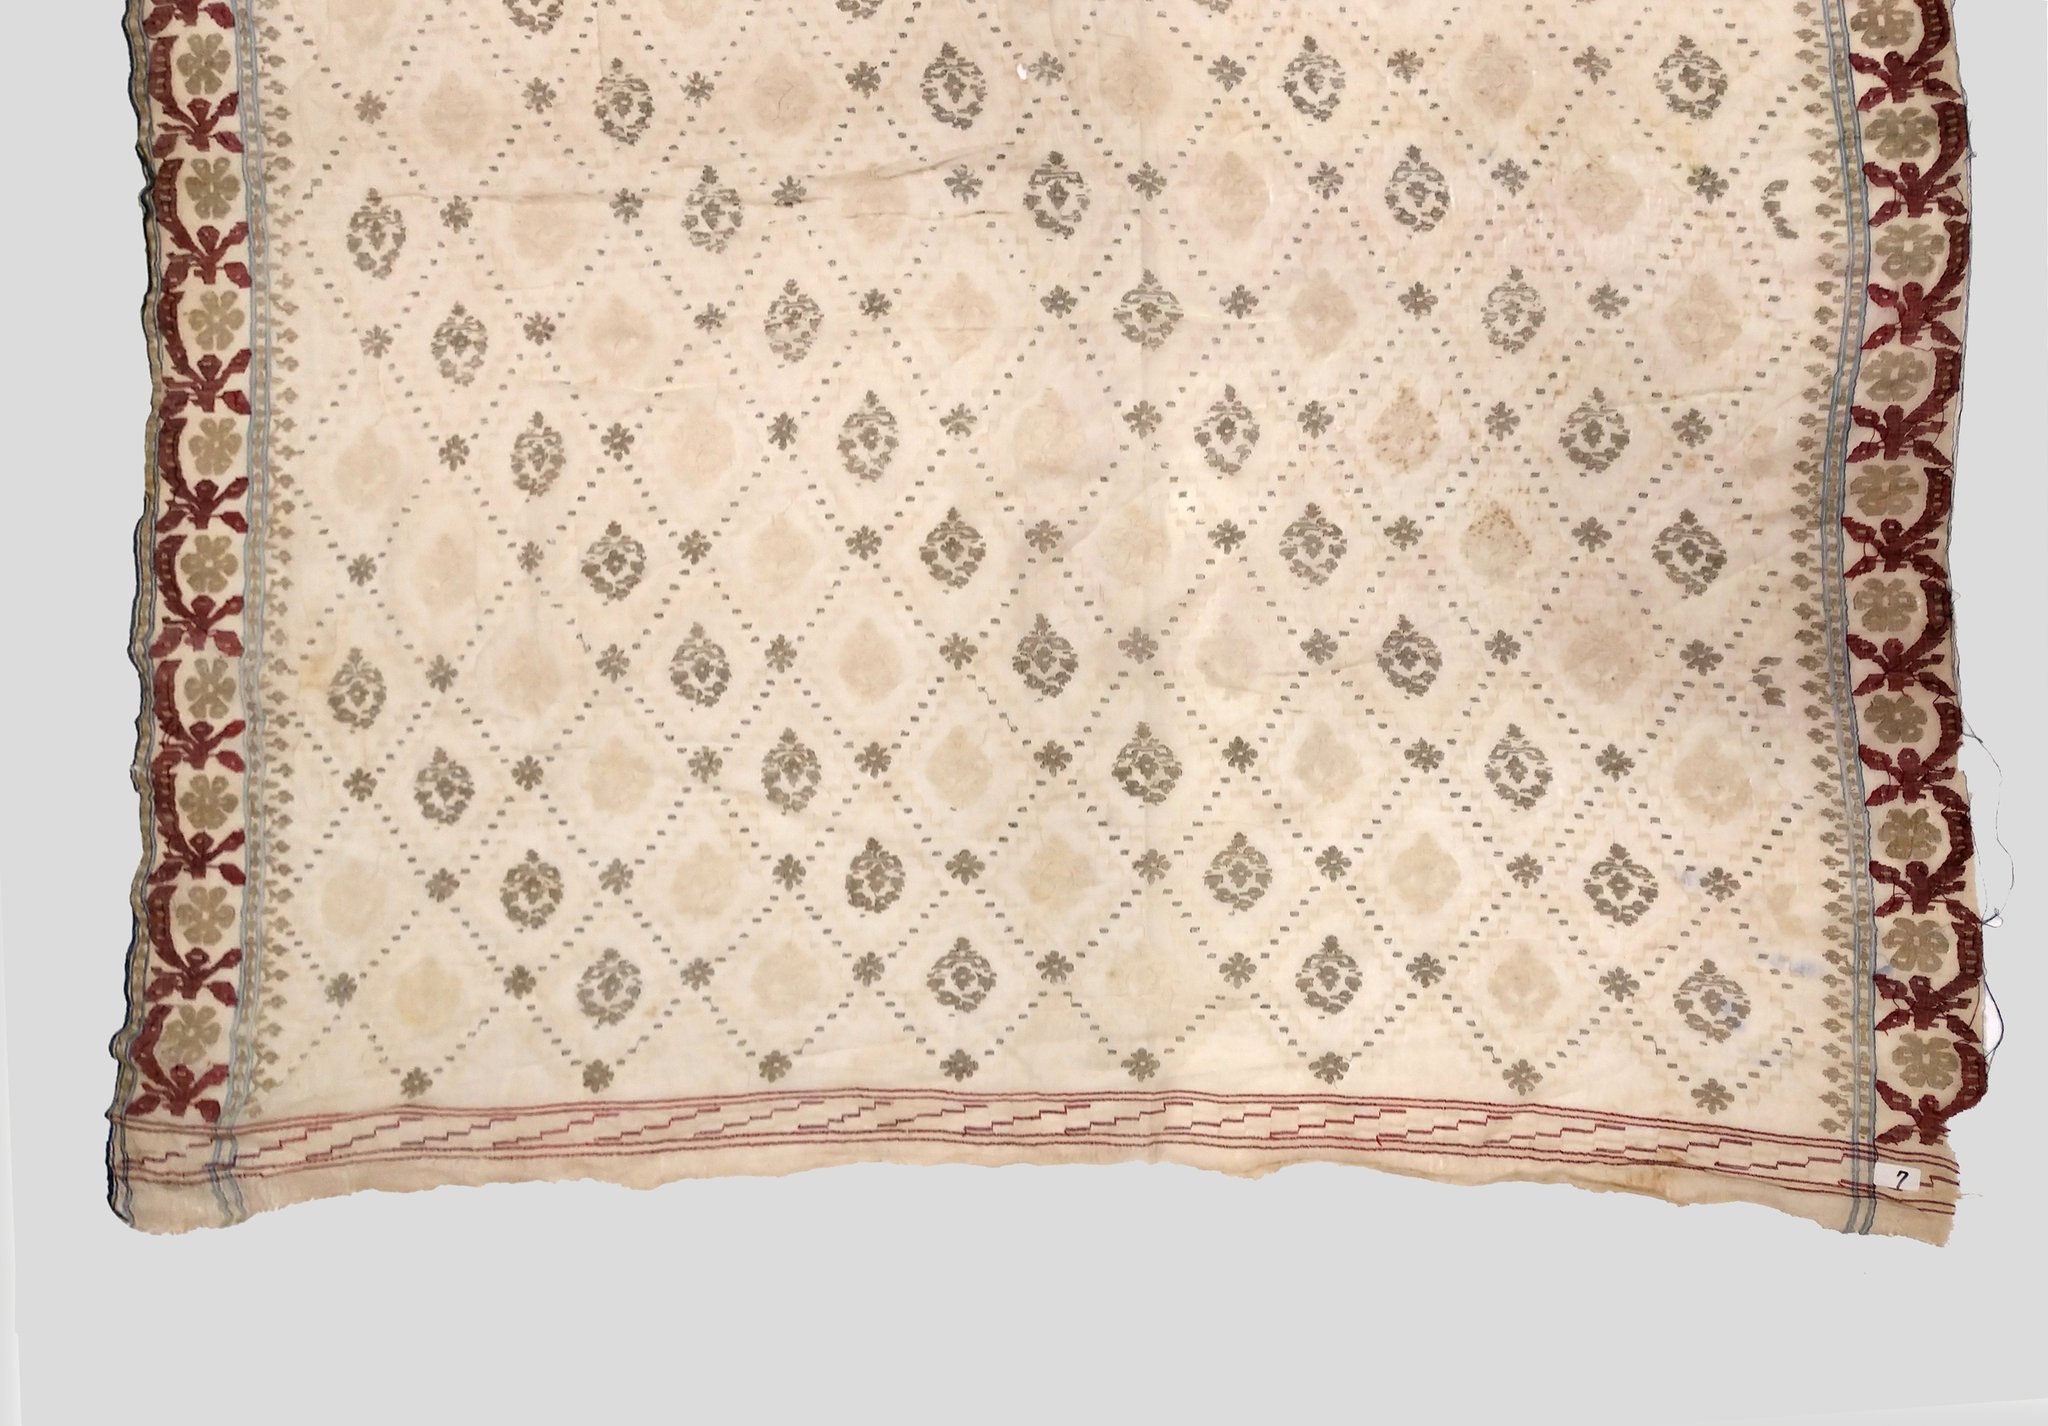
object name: textile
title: Sari-length textile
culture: bangladesh, dacca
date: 1801-1933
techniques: weave